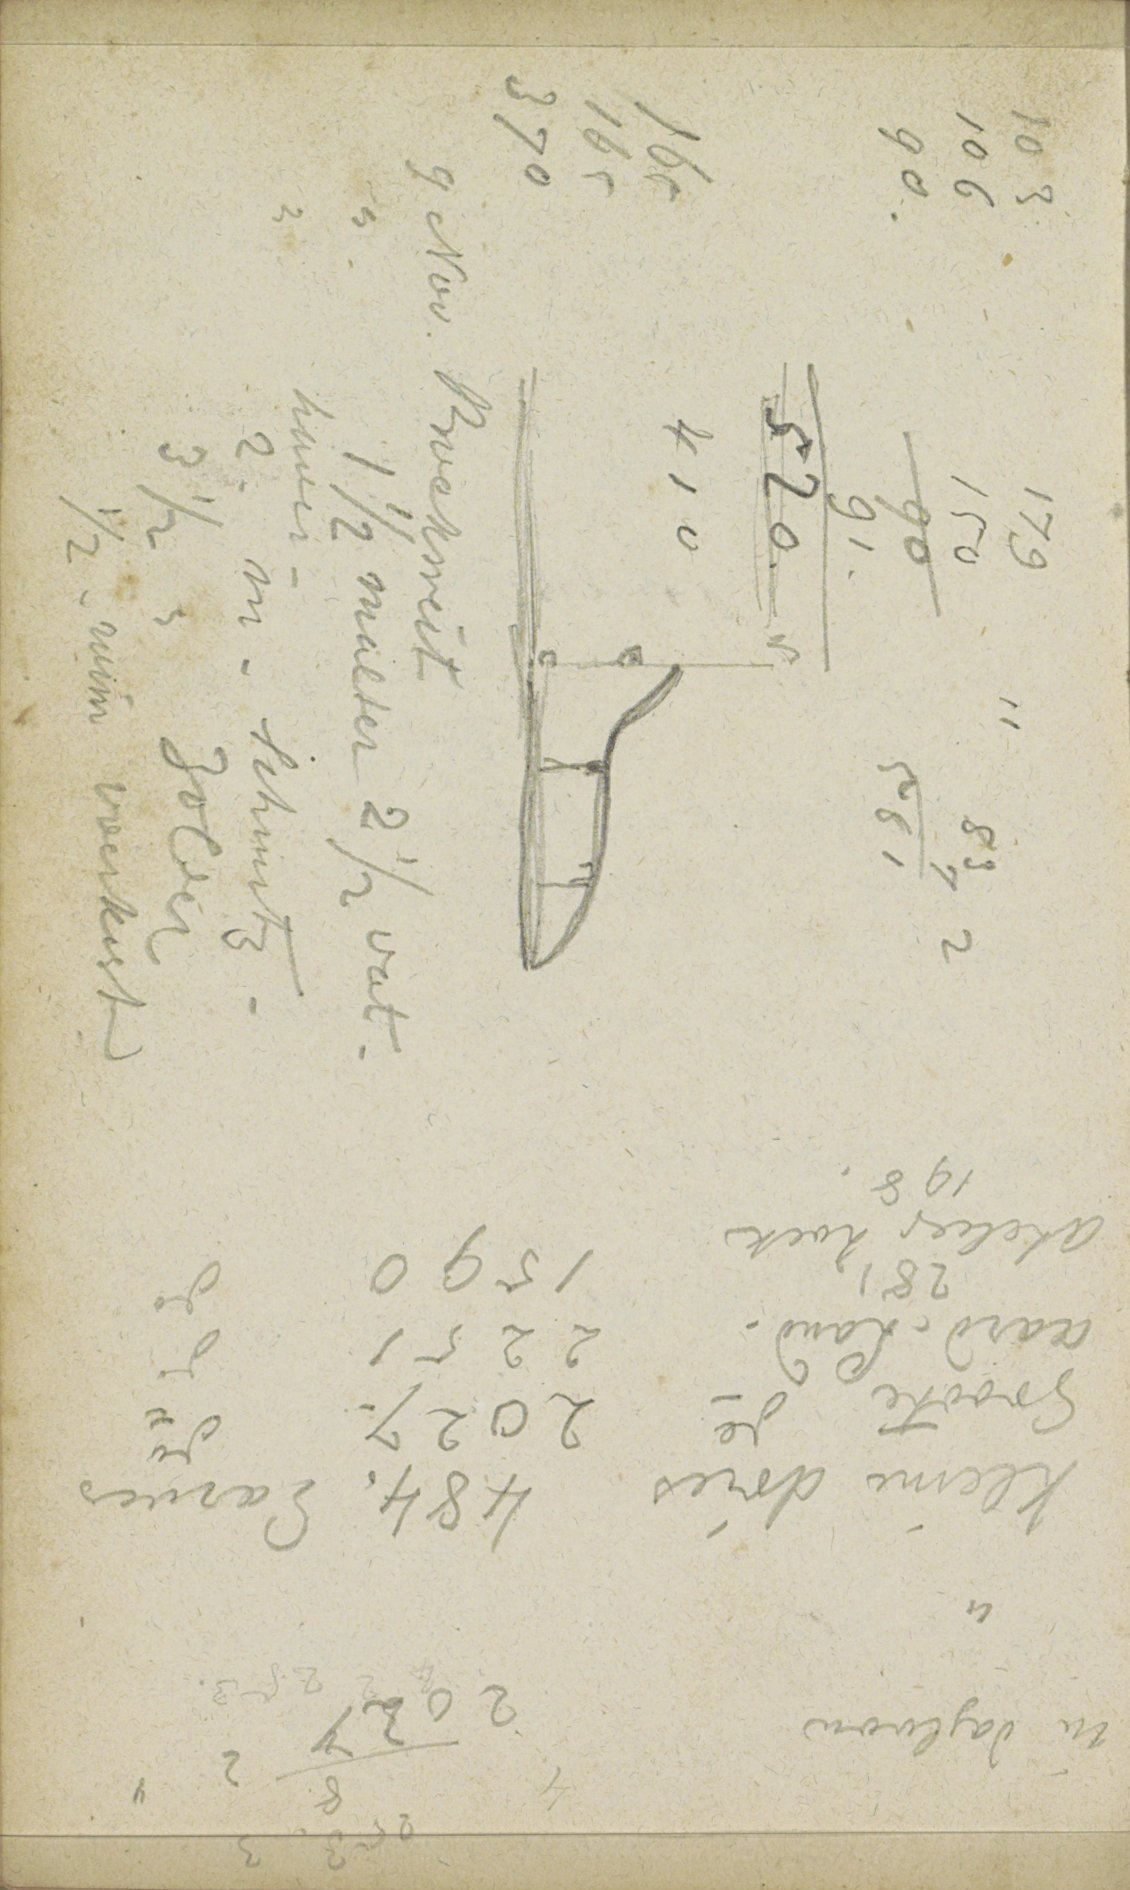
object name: sketchbook leaf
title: Notities en berekeningen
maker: johannes tavenraat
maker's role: draughtsman, painter, print maker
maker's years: 1809-1881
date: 1854-1868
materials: paper, pencil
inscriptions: annotation: ‘[...]’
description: Blad 86 verso uit een schetsboek met 88 bladen.